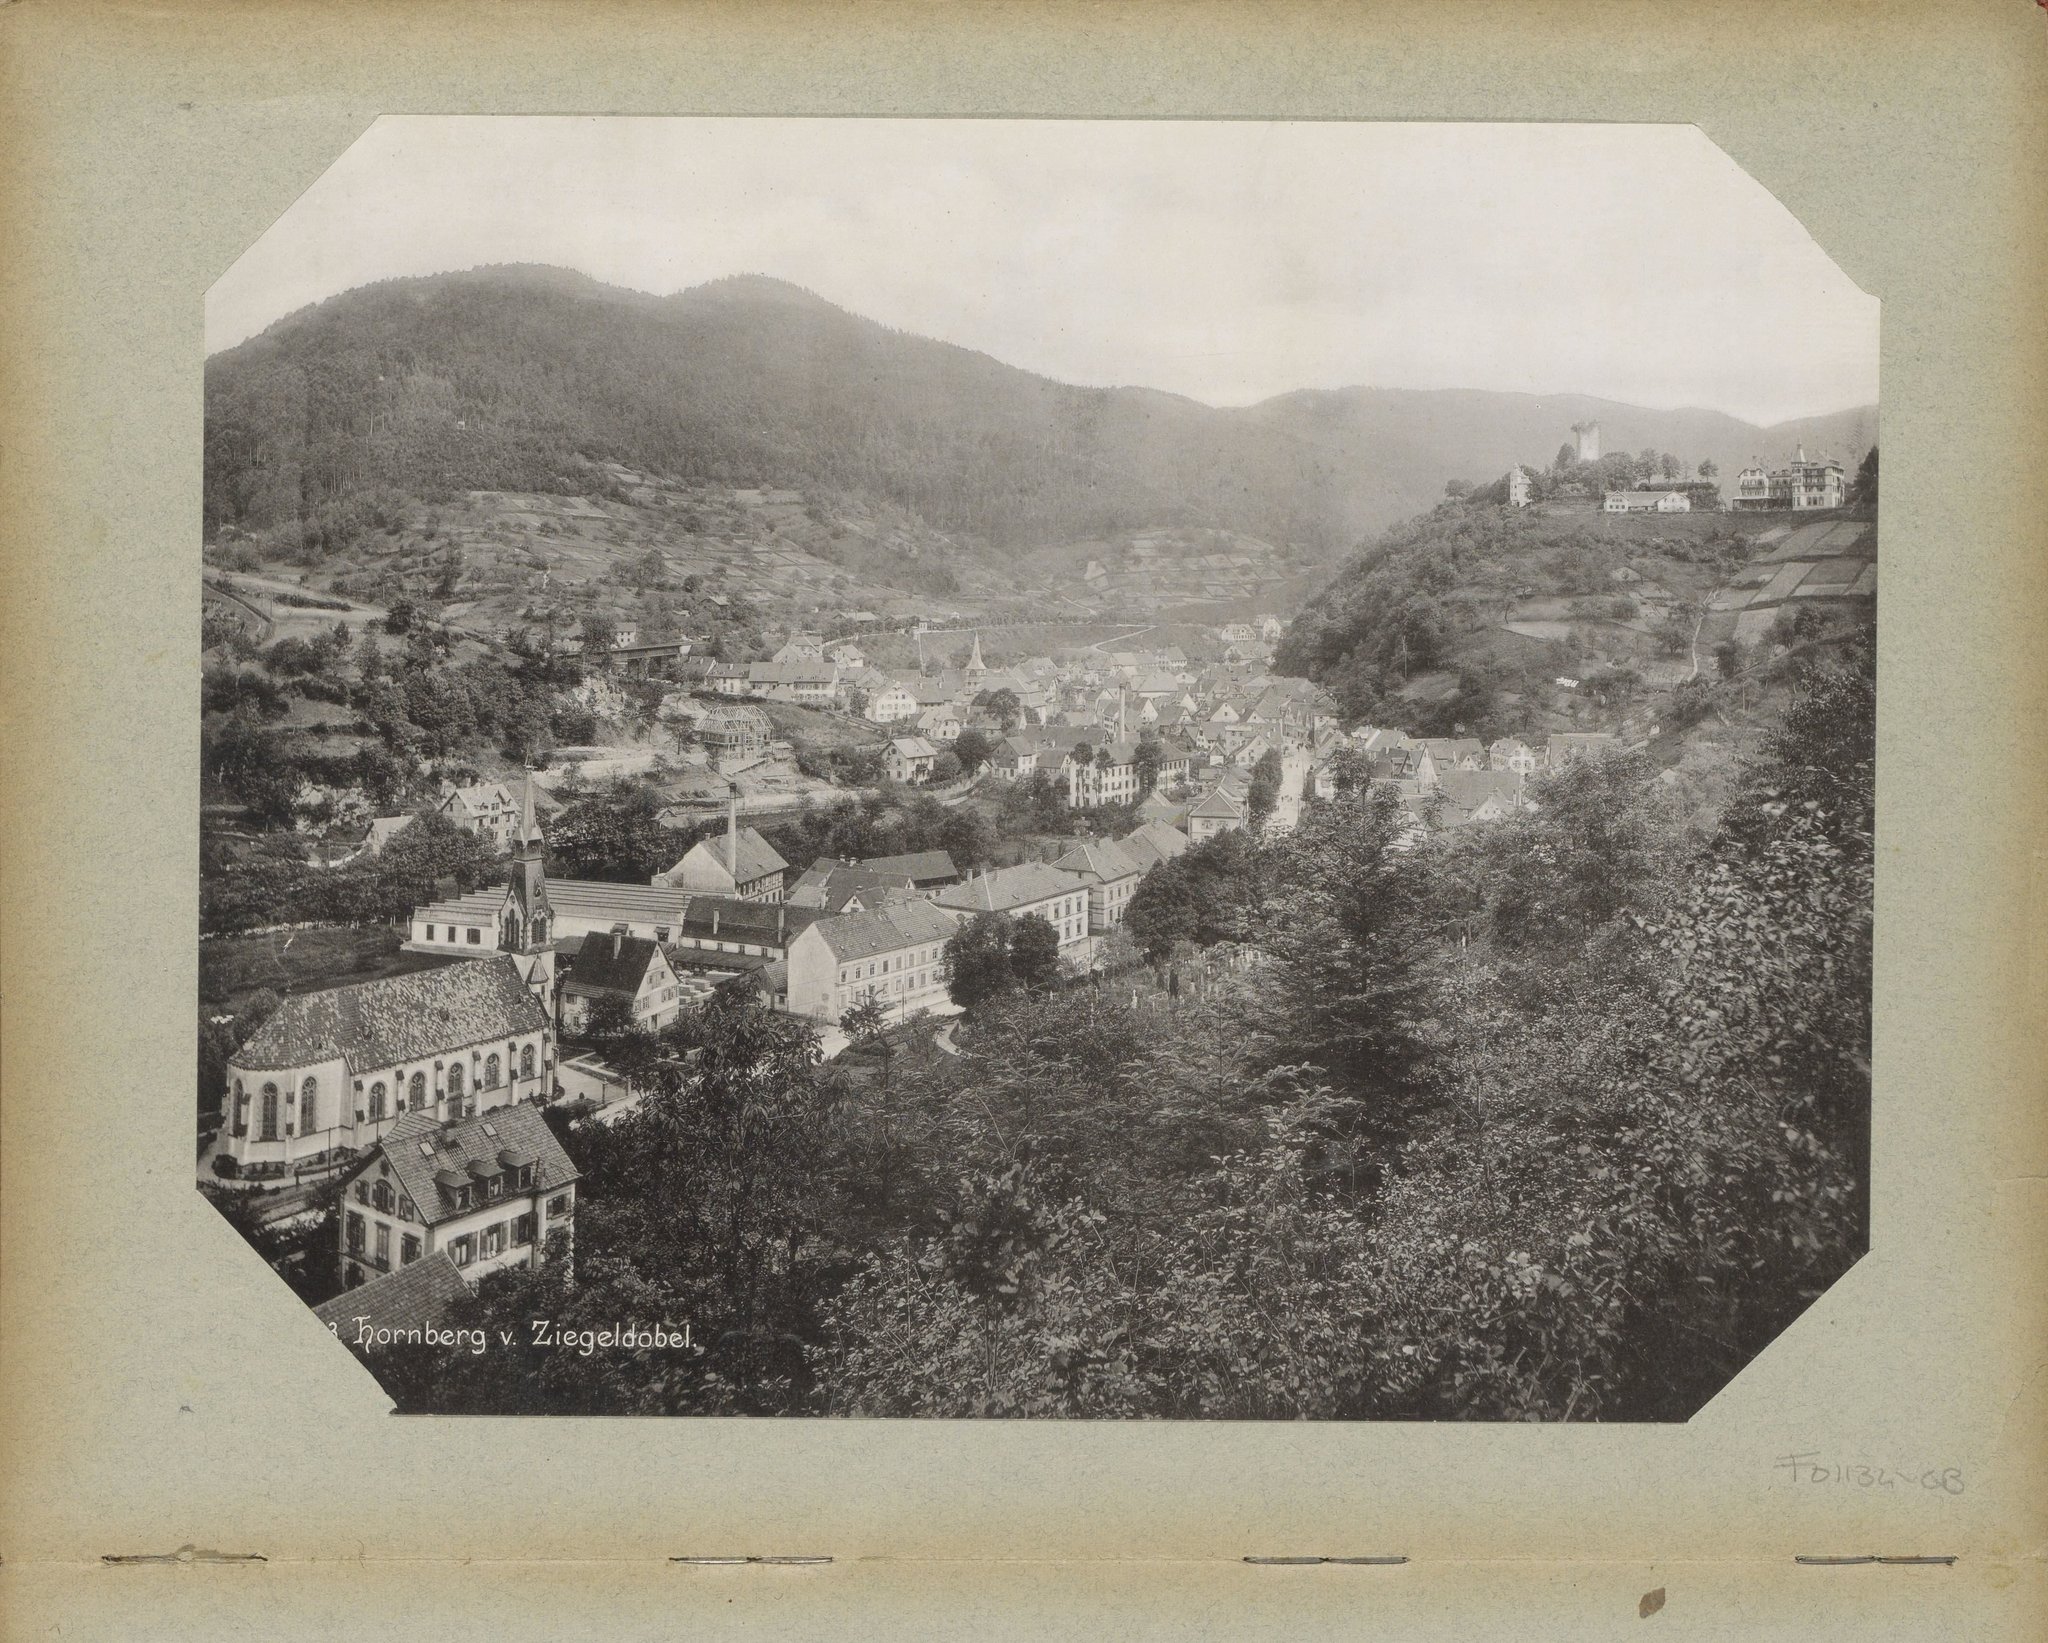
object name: photograph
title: Hornberg v. Ziegeldobel.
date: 1902-1910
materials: paper, ink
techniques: photograph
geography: hornberg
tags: prospect of village, silhouette of village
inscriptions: inscription: ‘Verlag Carl Aberle, Hornberg. Ges. geschützt 1902.’, number: ‘C.493’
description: Onderdeel van Reisalbum met bezienswaardigheden in Engeland, Zwitserland, Frankrijk en Duitsland.